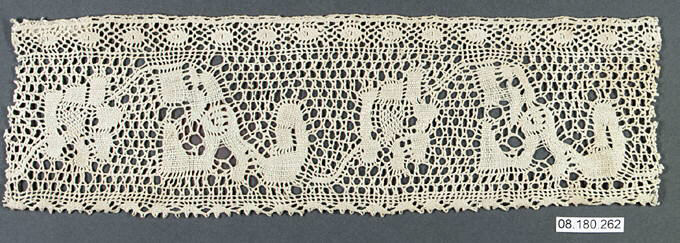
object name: fragment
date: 1801-1900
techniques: lace